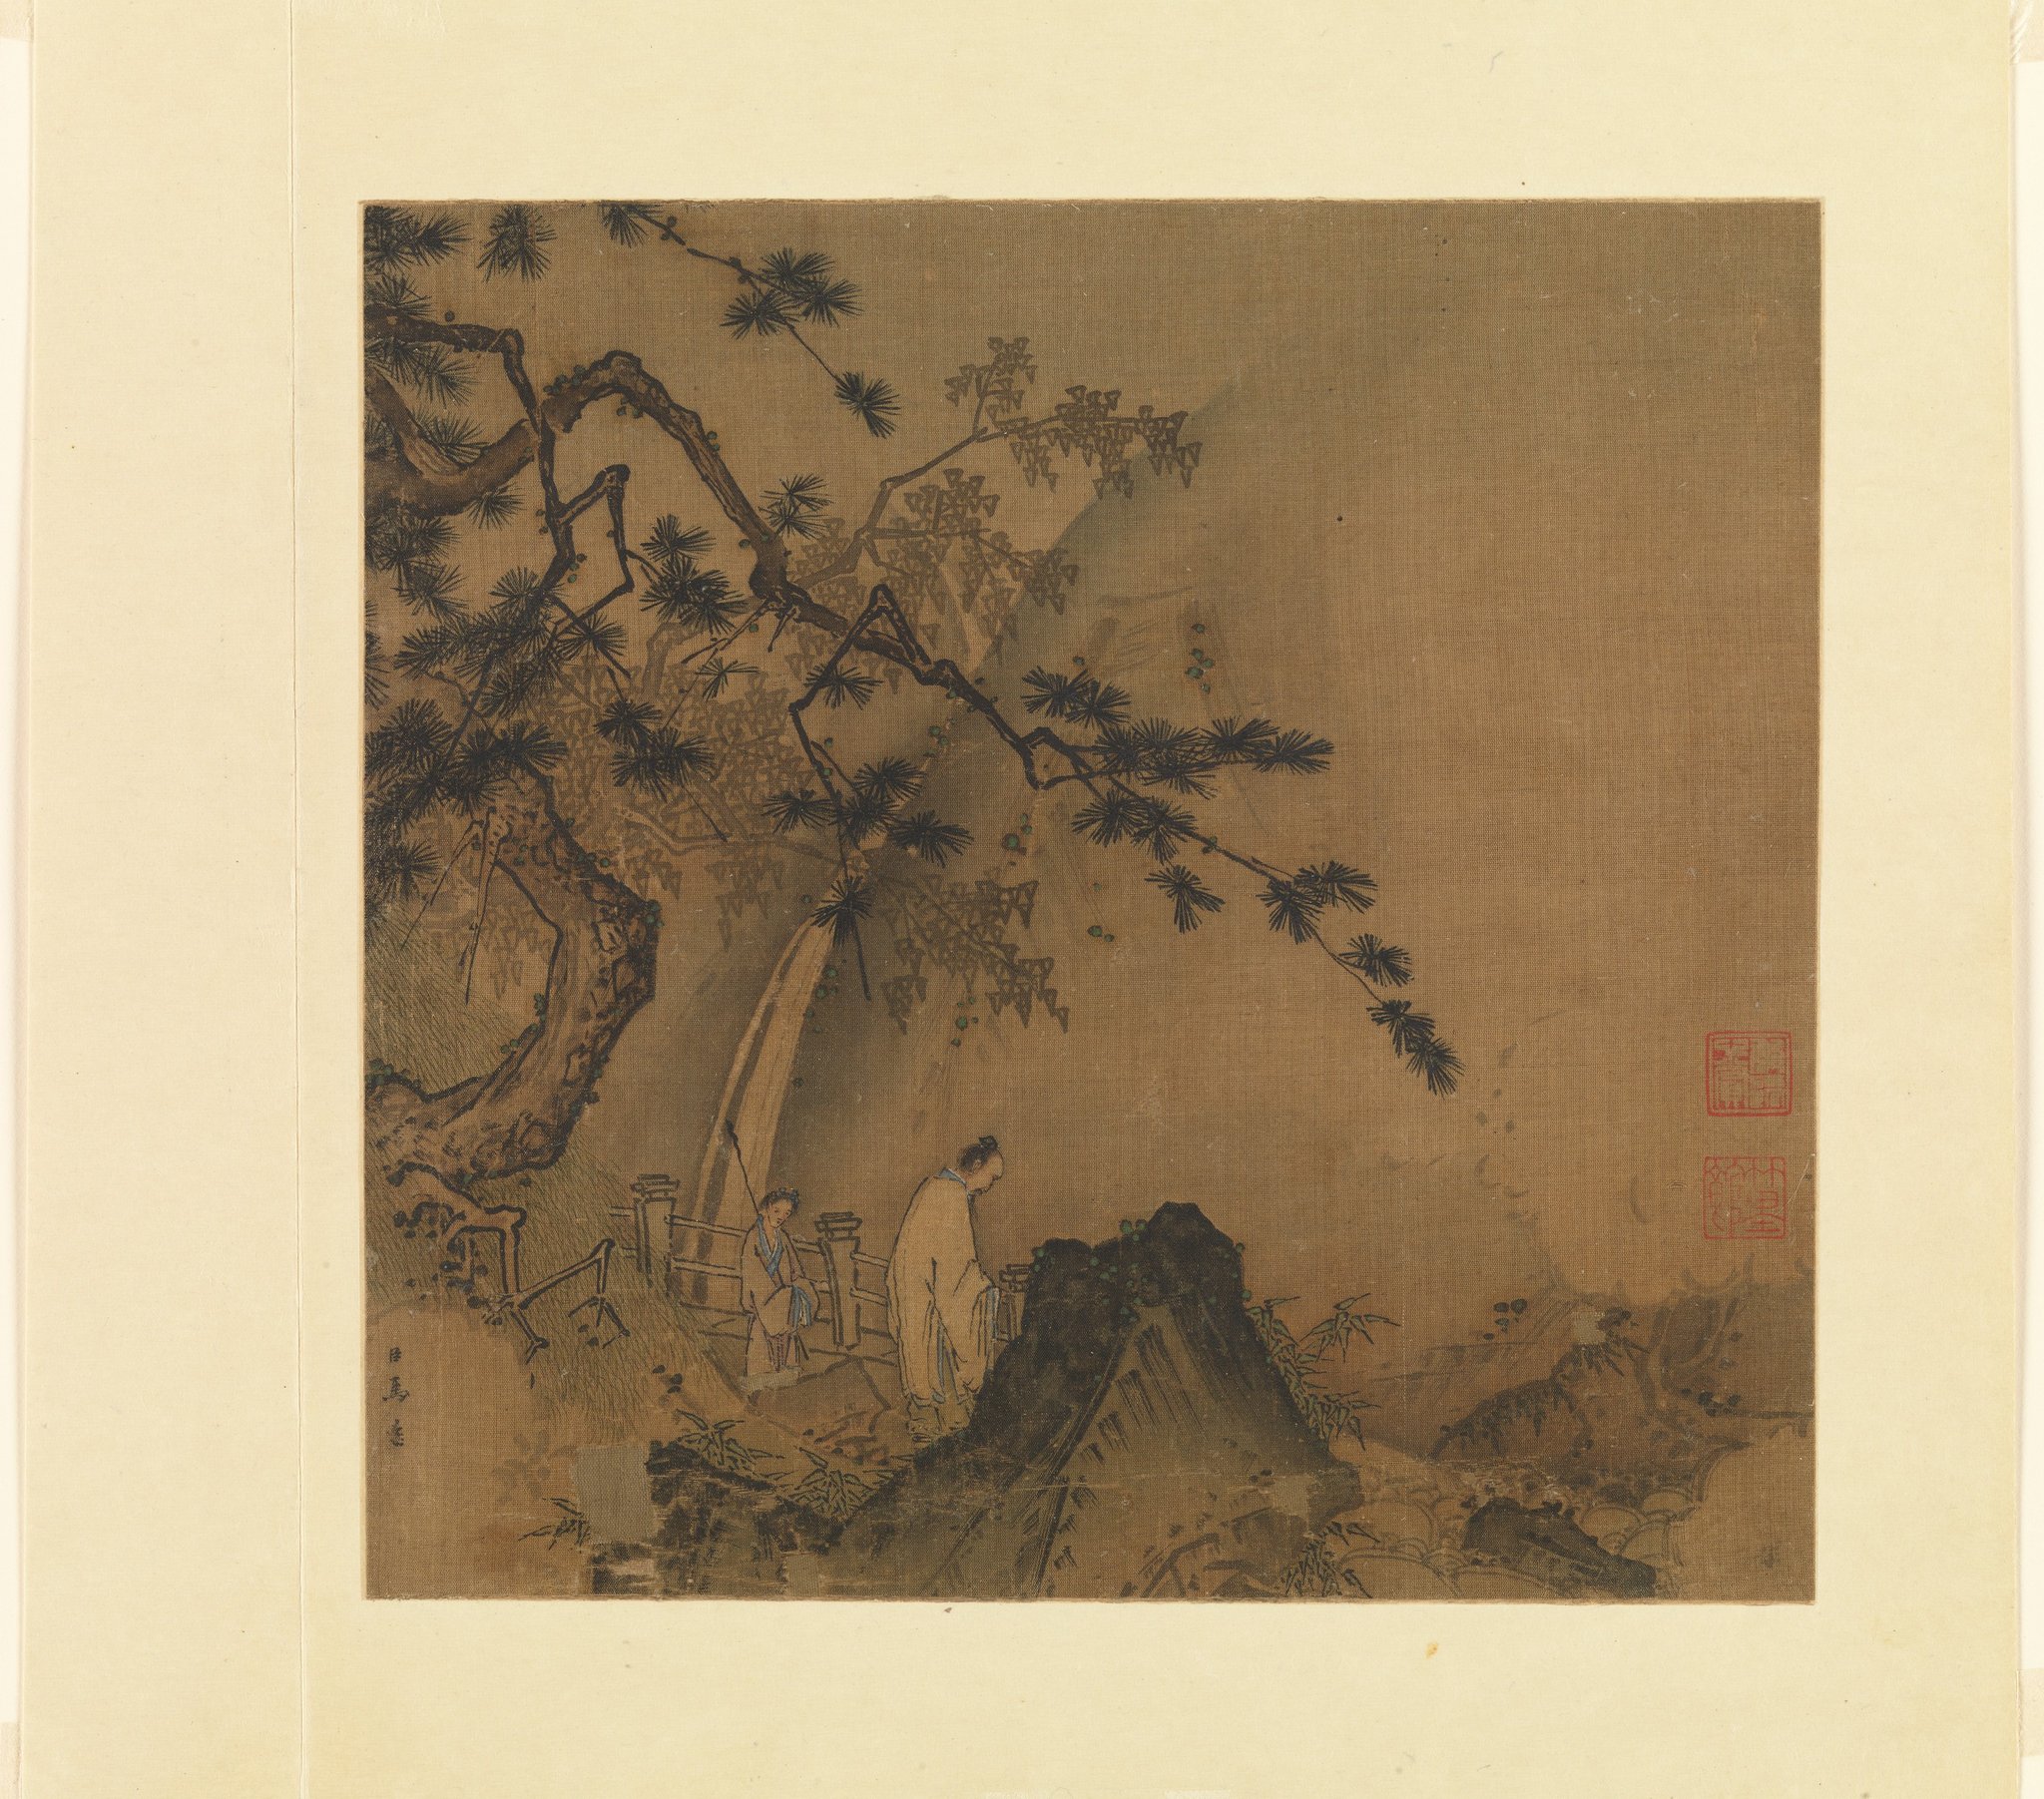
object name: album leaf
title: Scholar viewing a waterfall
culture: chinese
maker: ma yuan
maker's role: artist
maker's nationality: chinese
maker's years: 1190-1225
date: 1201-1233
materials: ink, silk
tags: men,waterfalls,trees